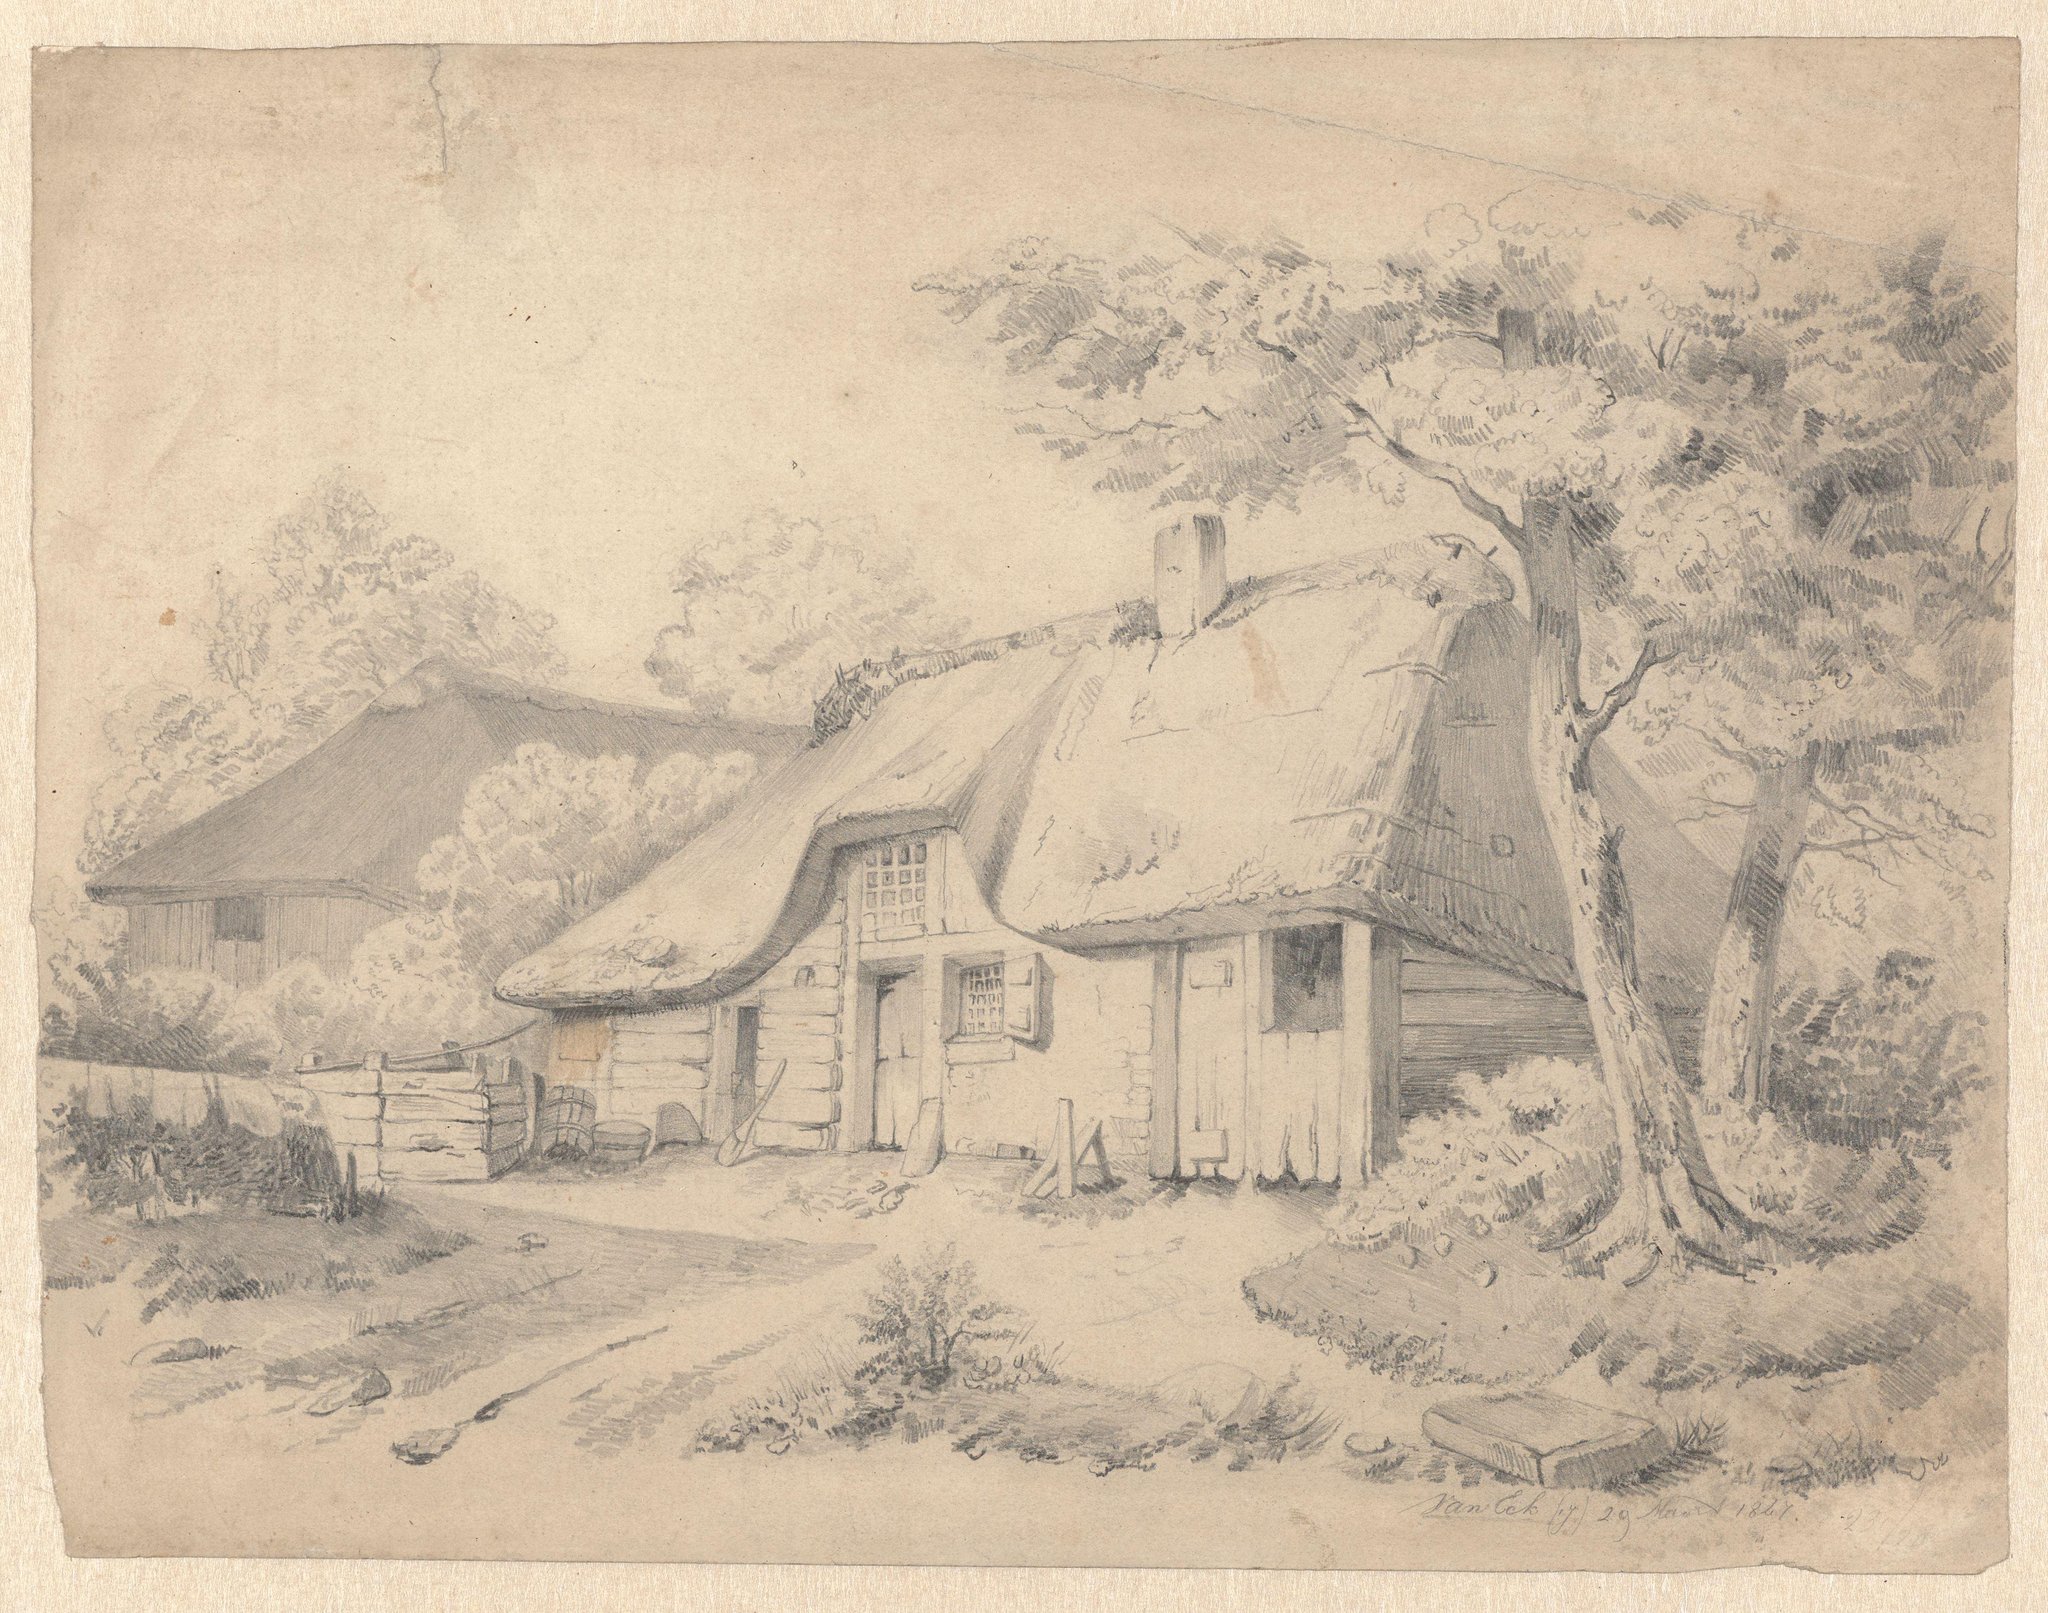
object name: drawing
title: Boerenhoeve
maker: j. van eck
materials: paper, pencil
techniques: brush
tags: farm (building)